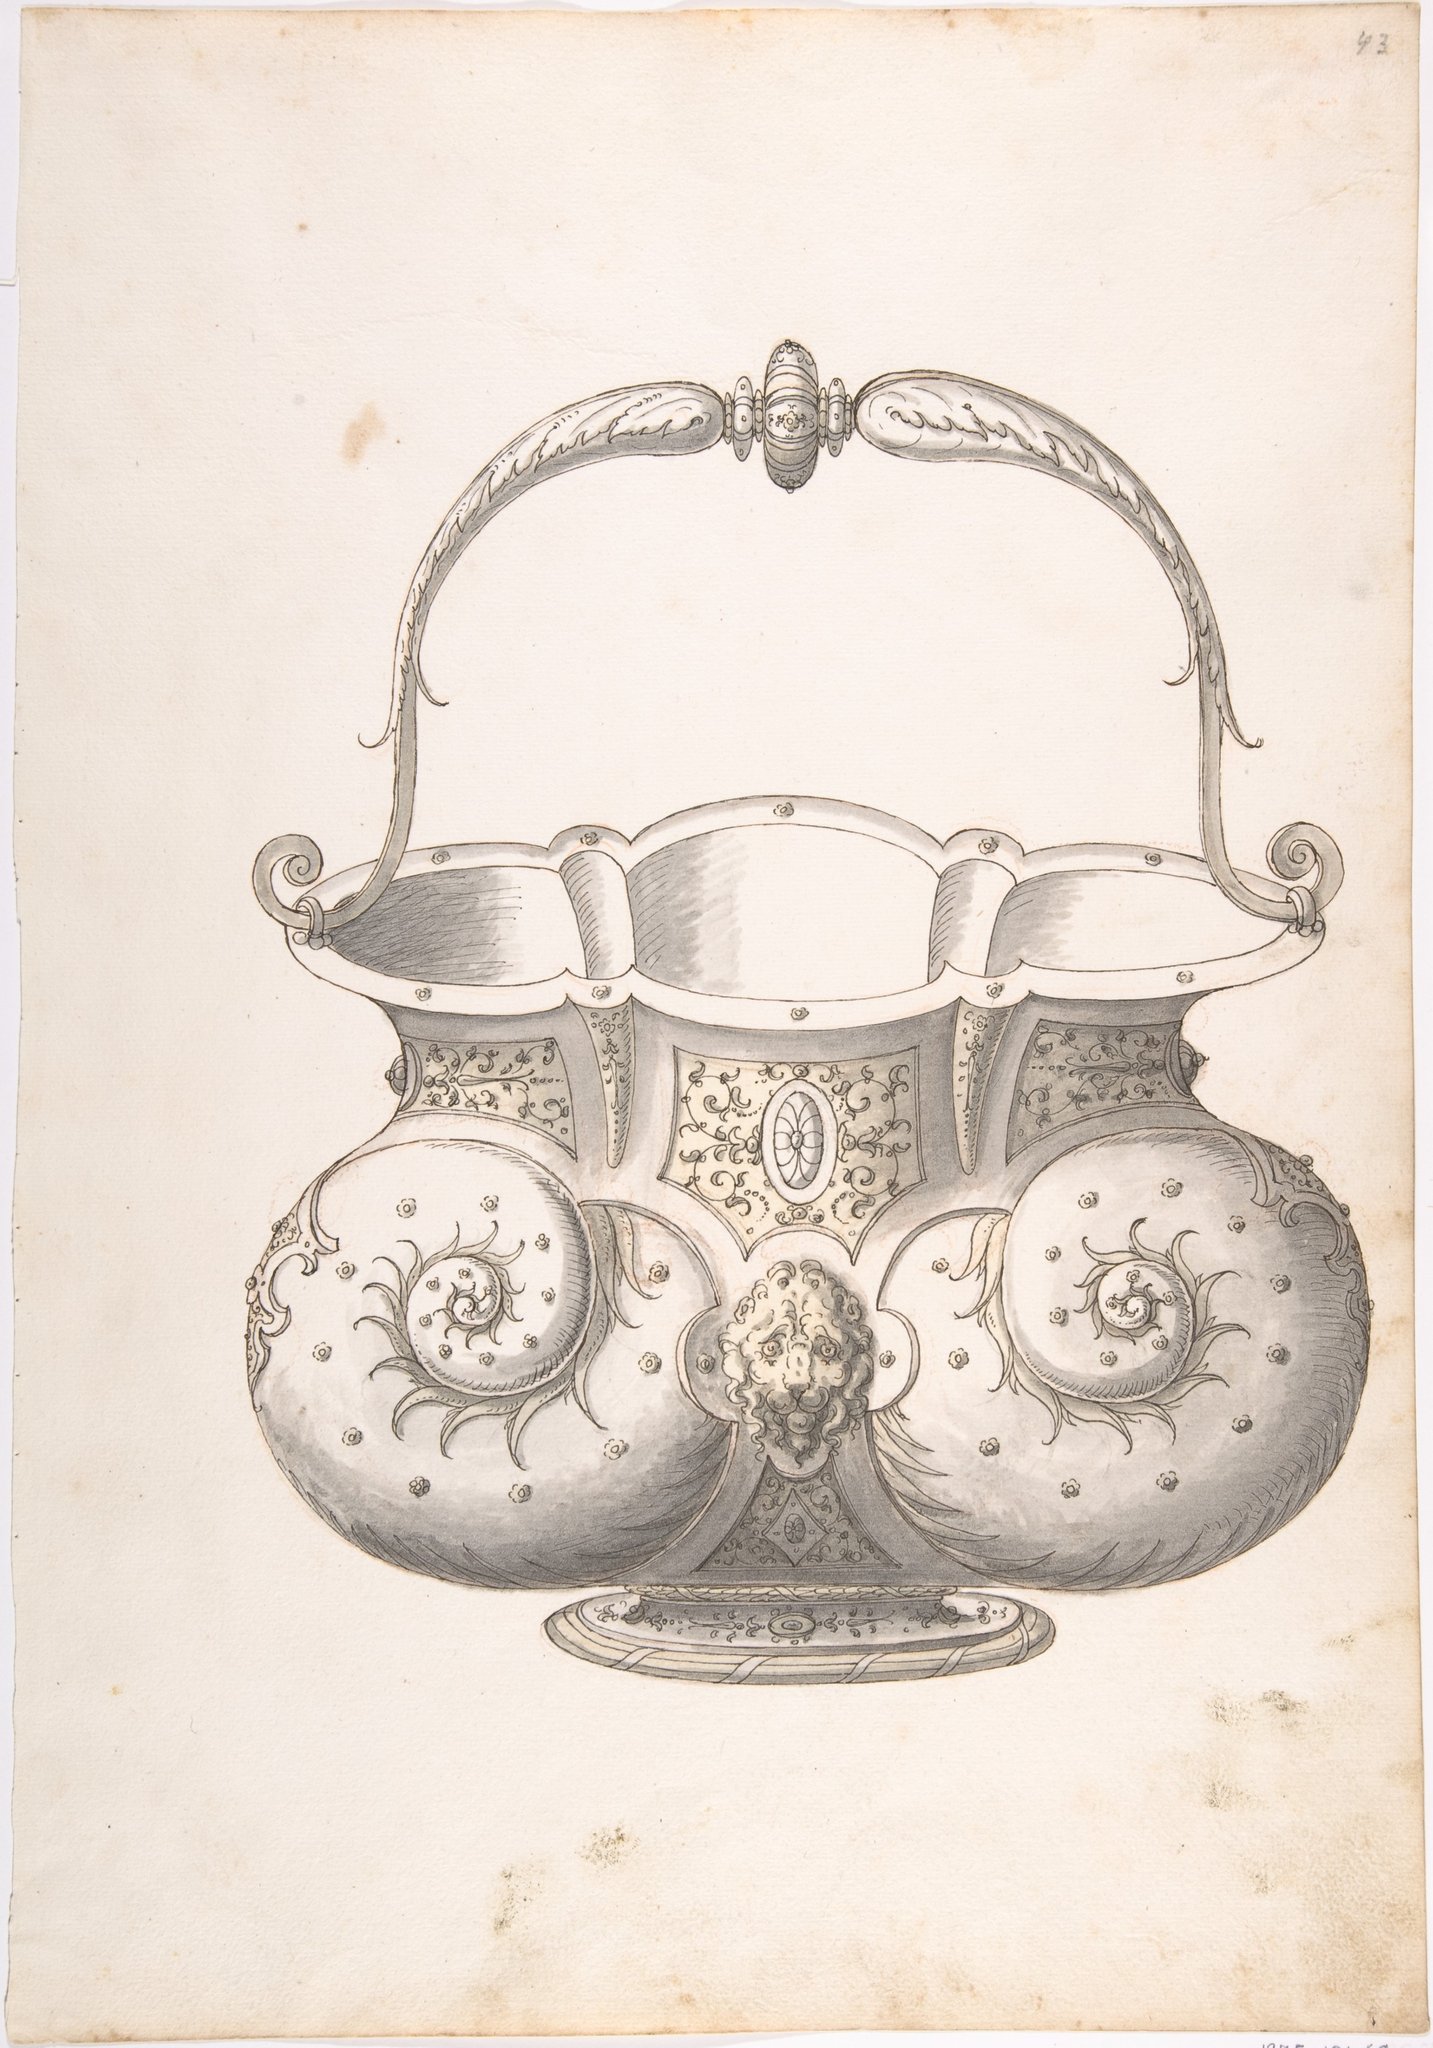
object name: drawing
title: Design for a Bucket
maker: erasmus hornick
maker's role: architect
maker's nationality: netherlandish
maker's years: 1501-1583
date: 1501-1600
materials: chalk, ink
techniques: brush, pen, wash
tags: vessels